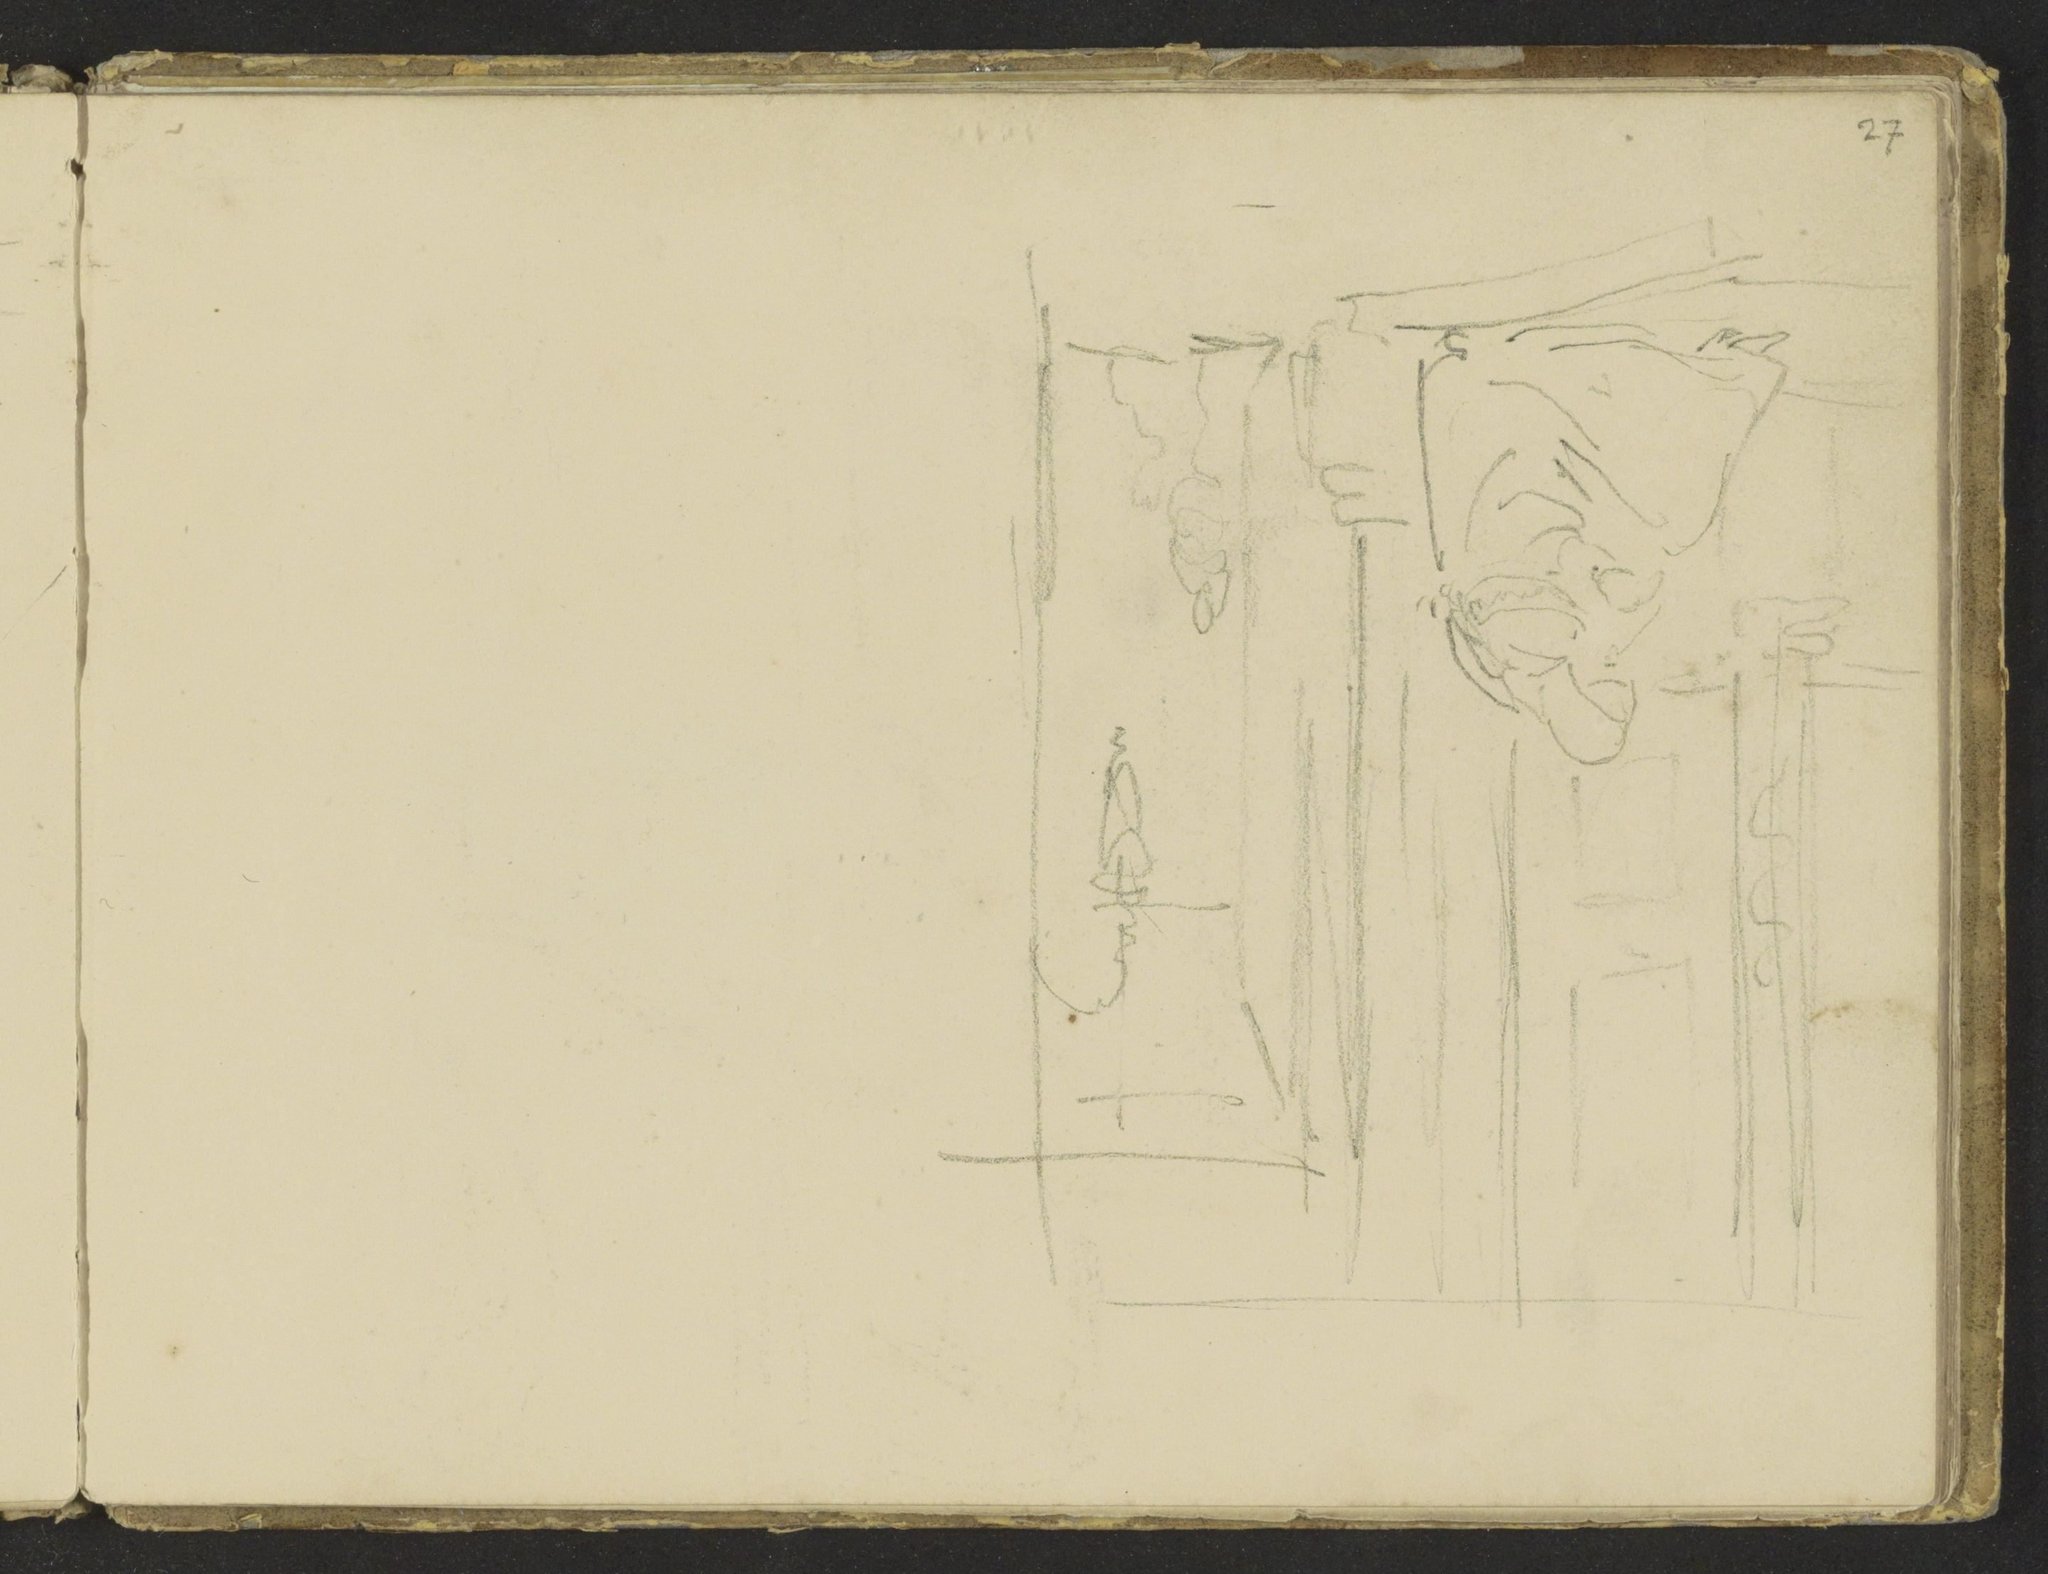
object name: sketchbook leaf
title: Zittende vrouw in een nis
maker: willem hendrik schmidt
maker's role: draughtsman, painter, print maker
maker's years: 1809-1849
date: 1819-1849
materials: paper, pencil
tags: sitting figure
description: Blad 27 recto uit een schetsboek met 36 bladen.